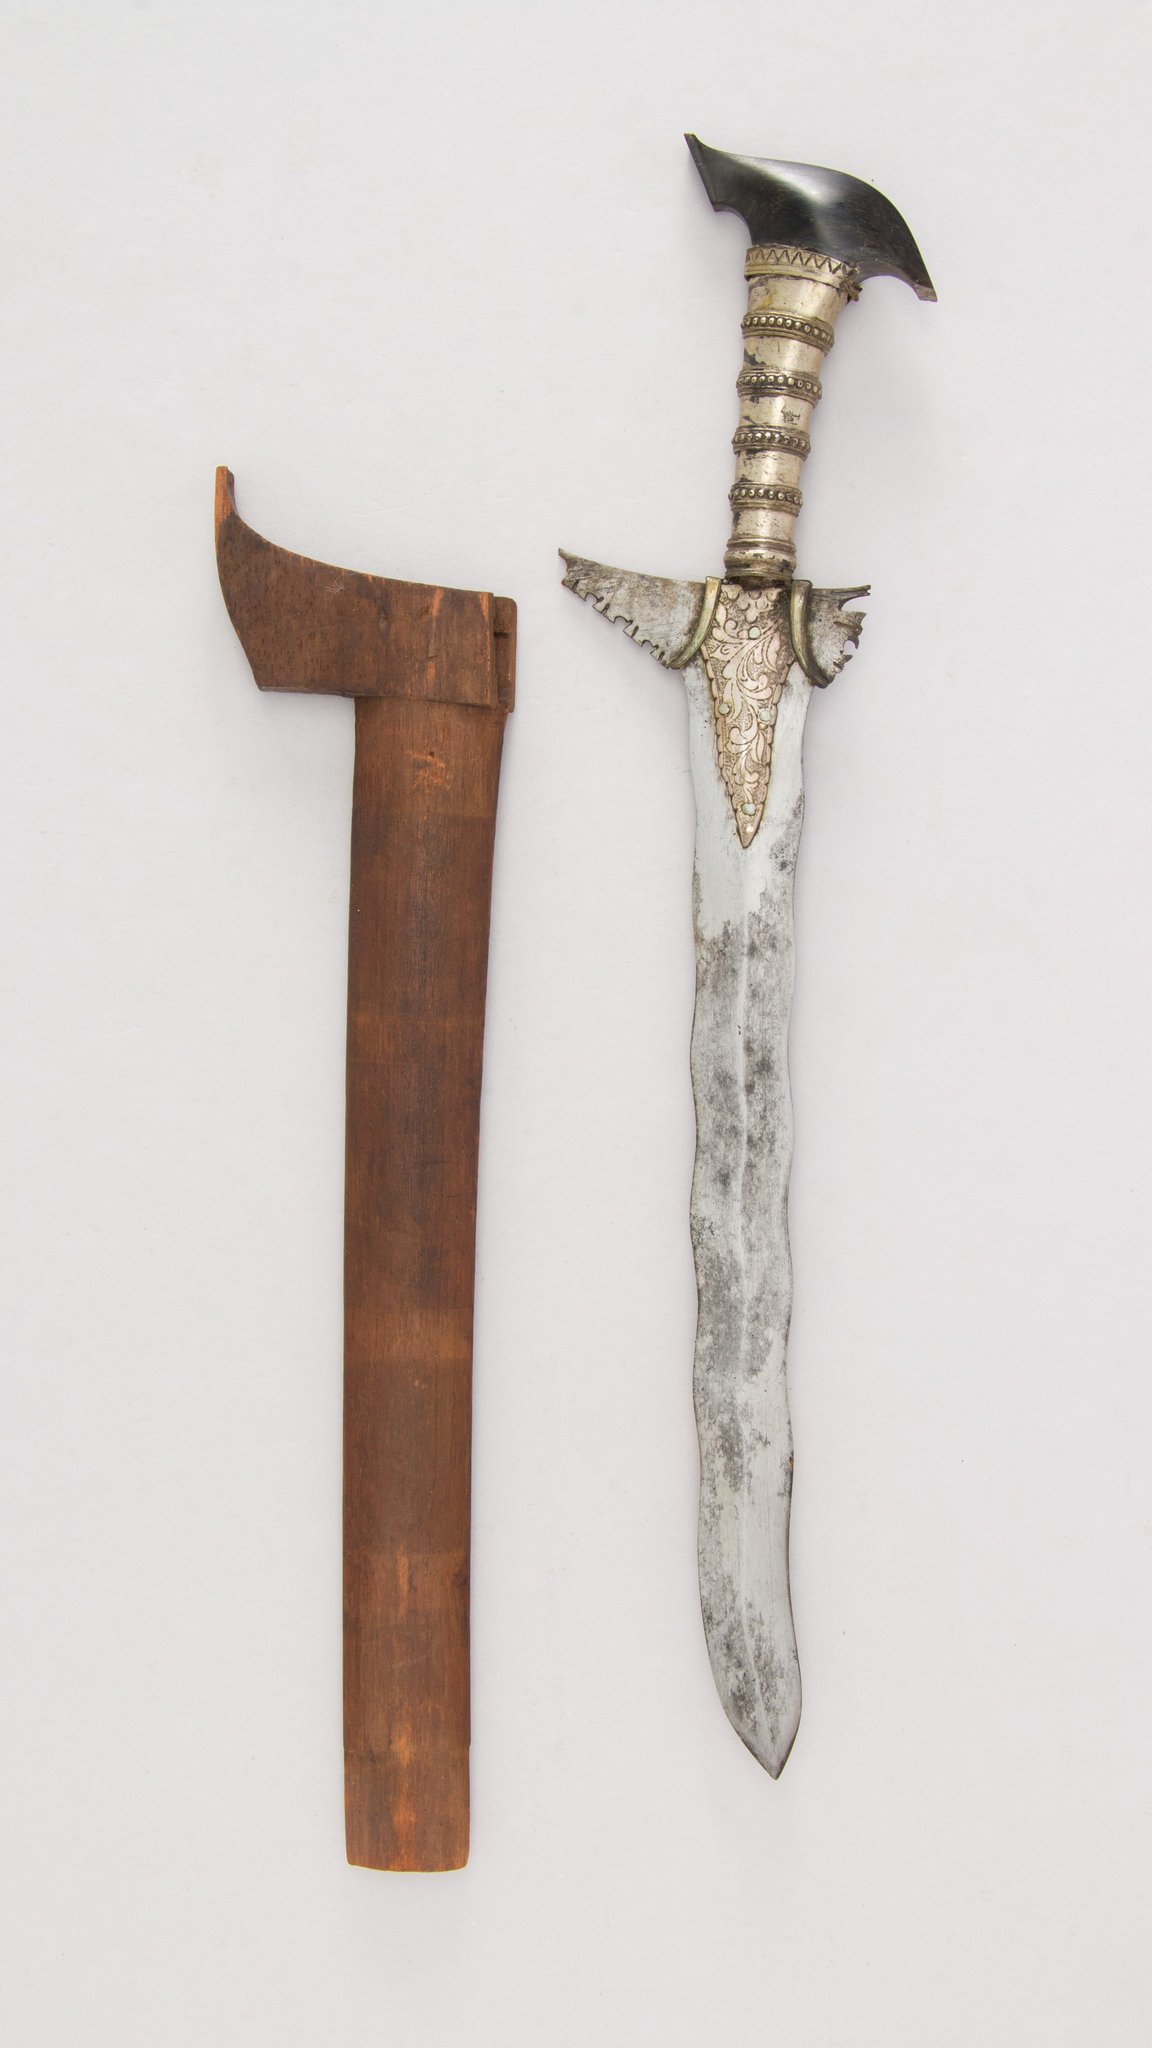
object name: kris with sheath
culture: philippine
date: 1701-1900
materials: horn, silver, steel, wood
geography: philippines